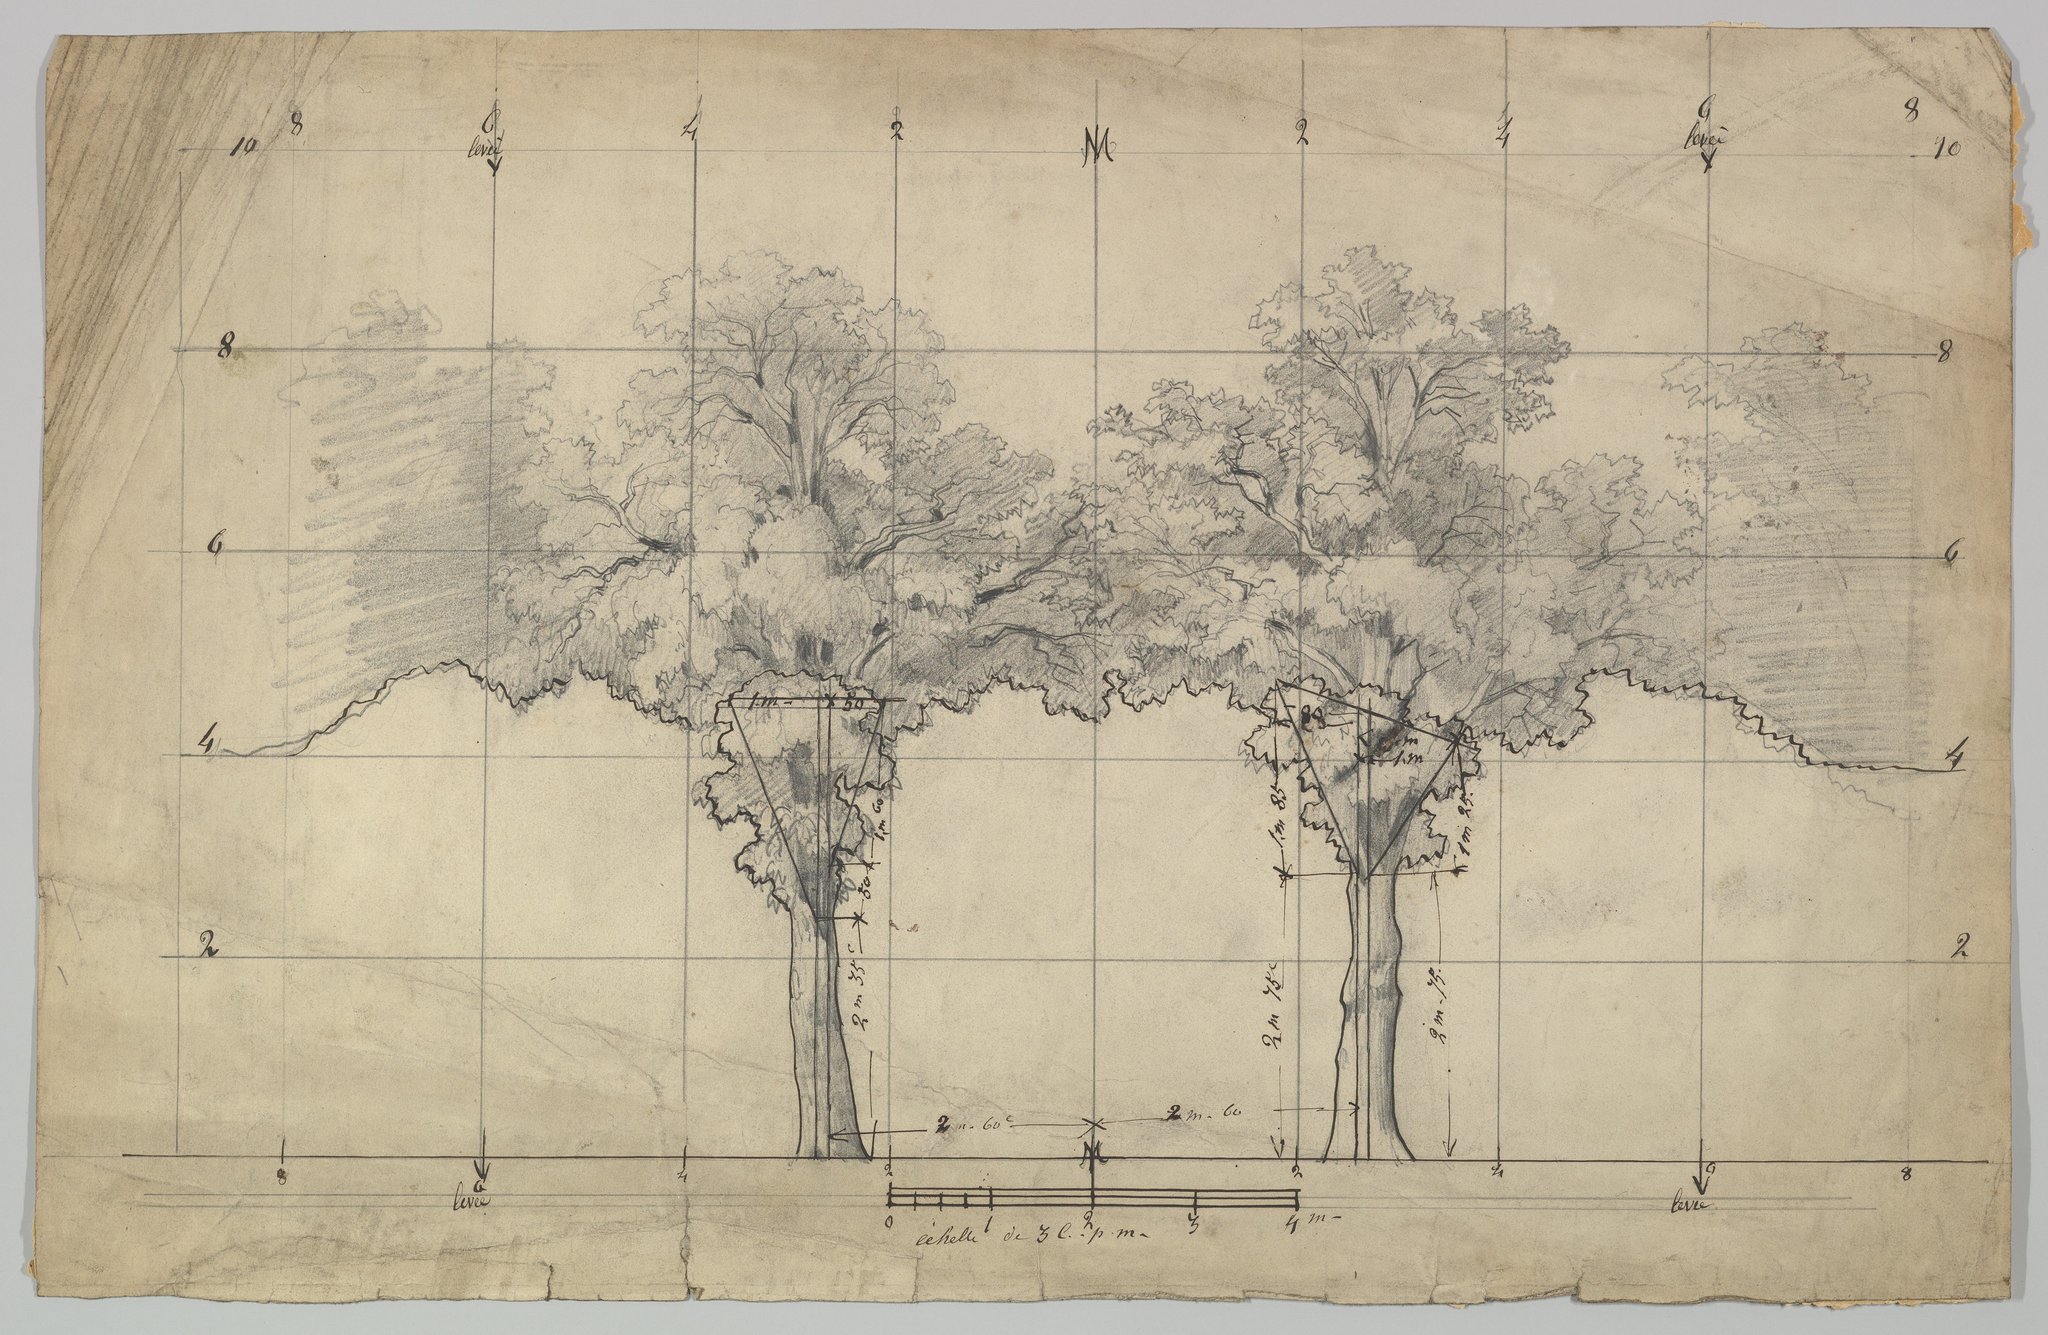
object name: drawing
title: Design for a Stage Set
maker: eugène cicéri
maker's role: artist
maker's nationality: french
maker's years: 1813-1890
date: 1828-1890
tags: trees,stage design